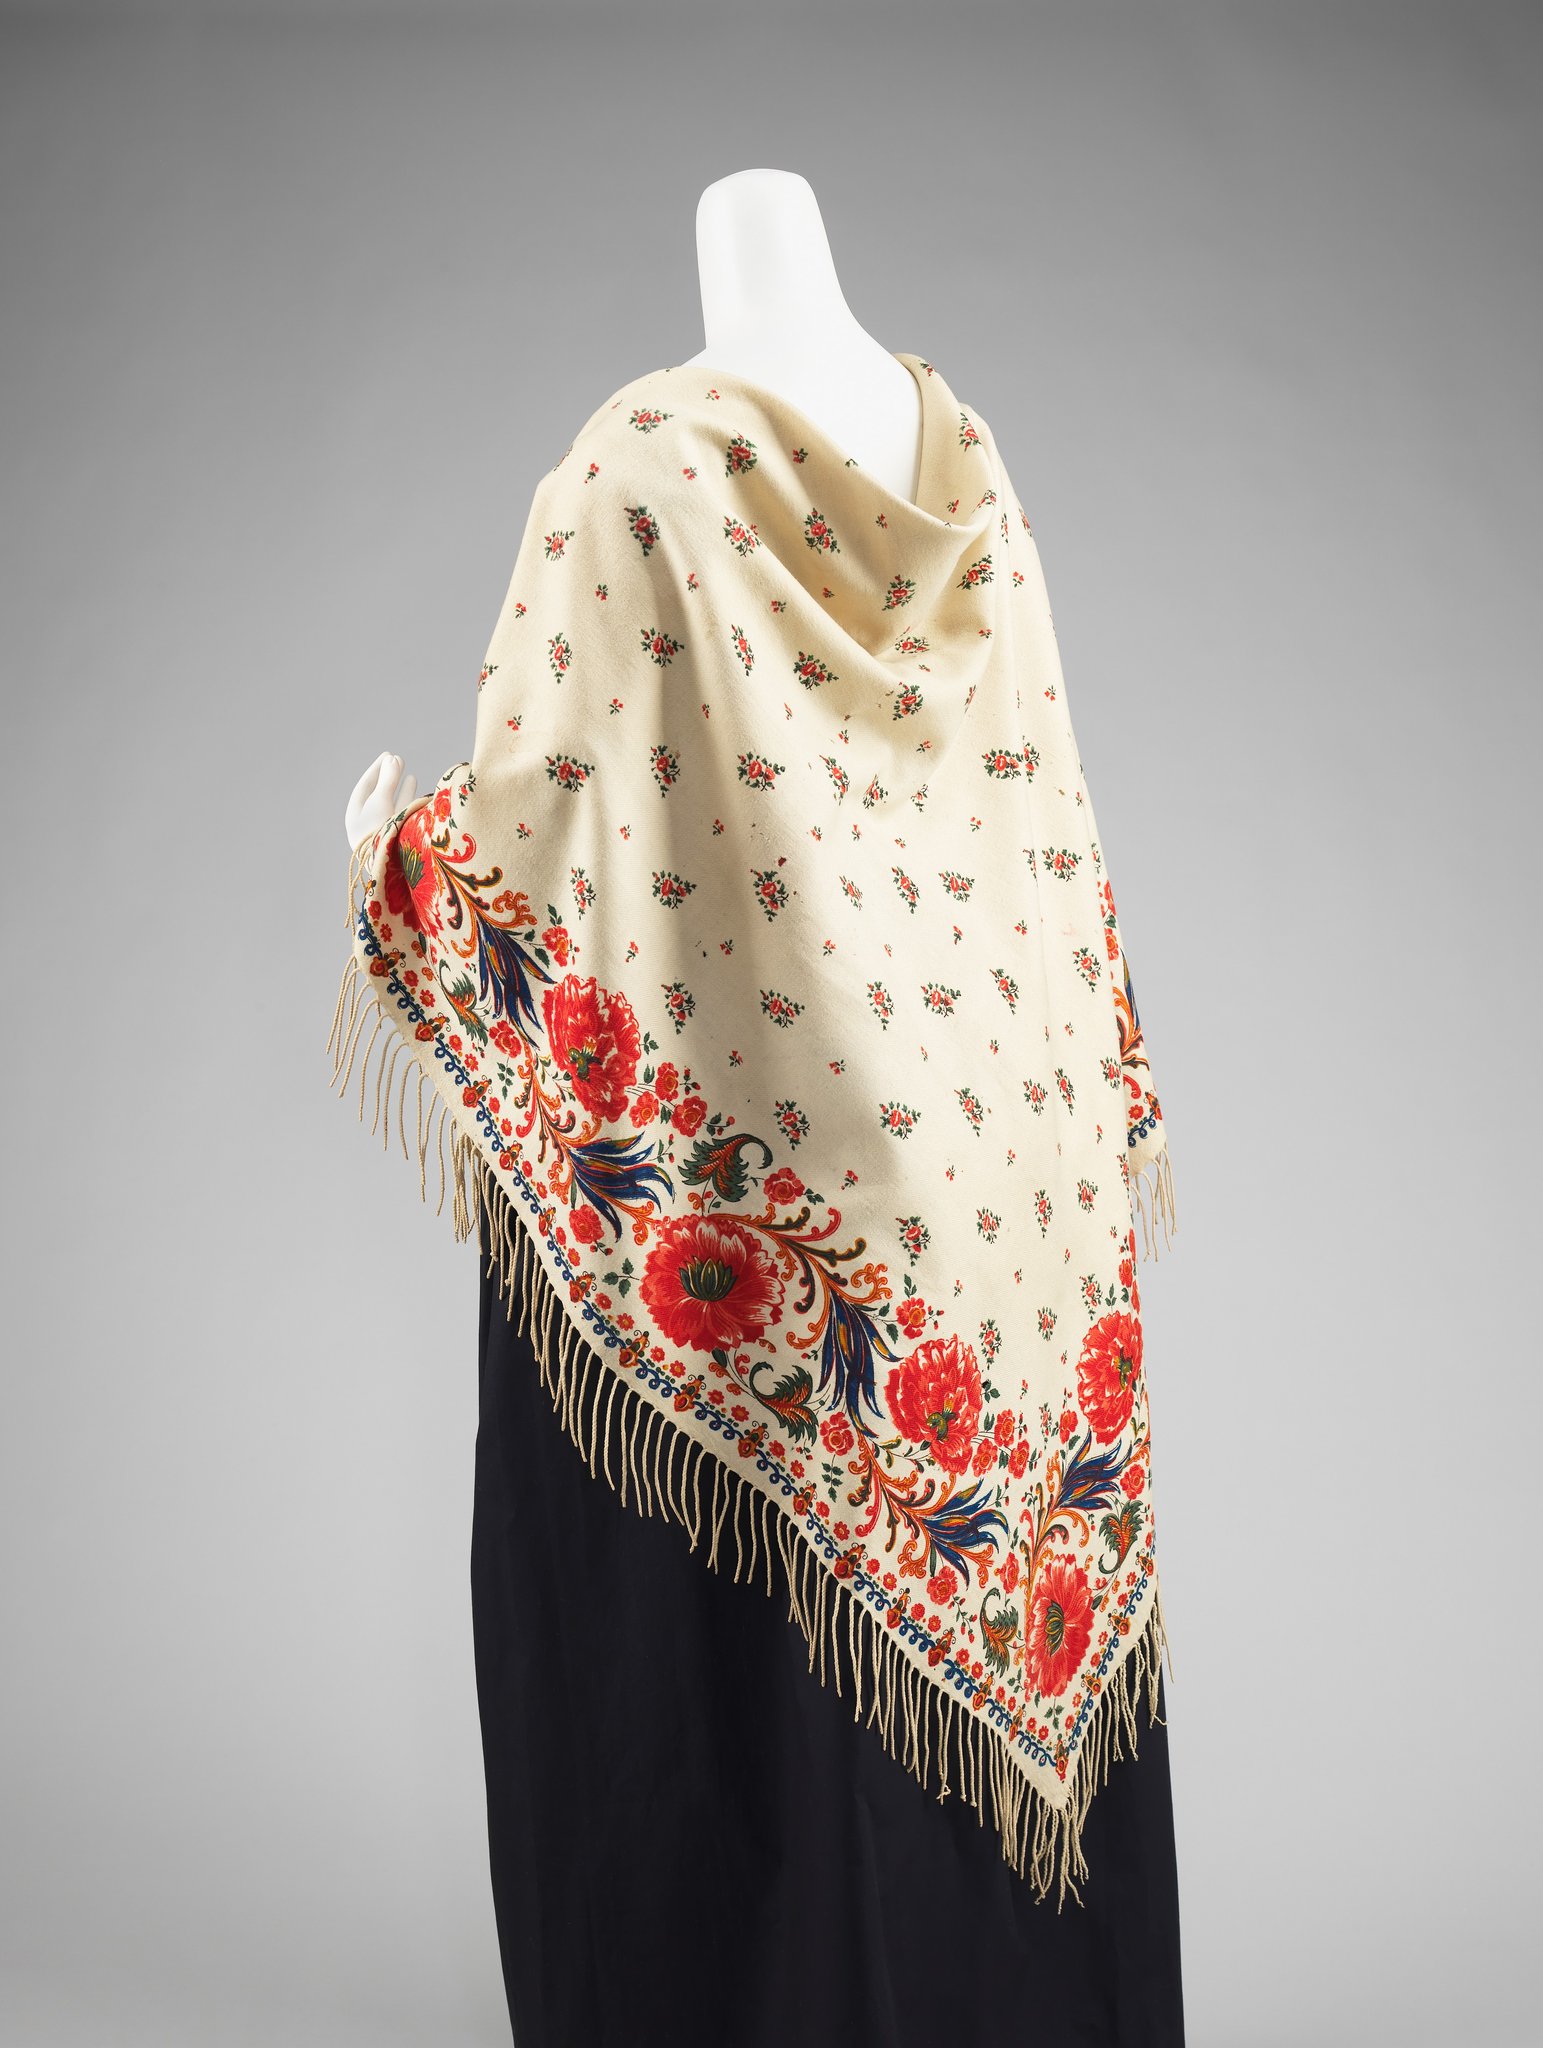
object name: shawl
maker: anton thum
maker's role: department store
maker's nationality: bohemian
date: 1876-1900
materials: wool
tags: flowers